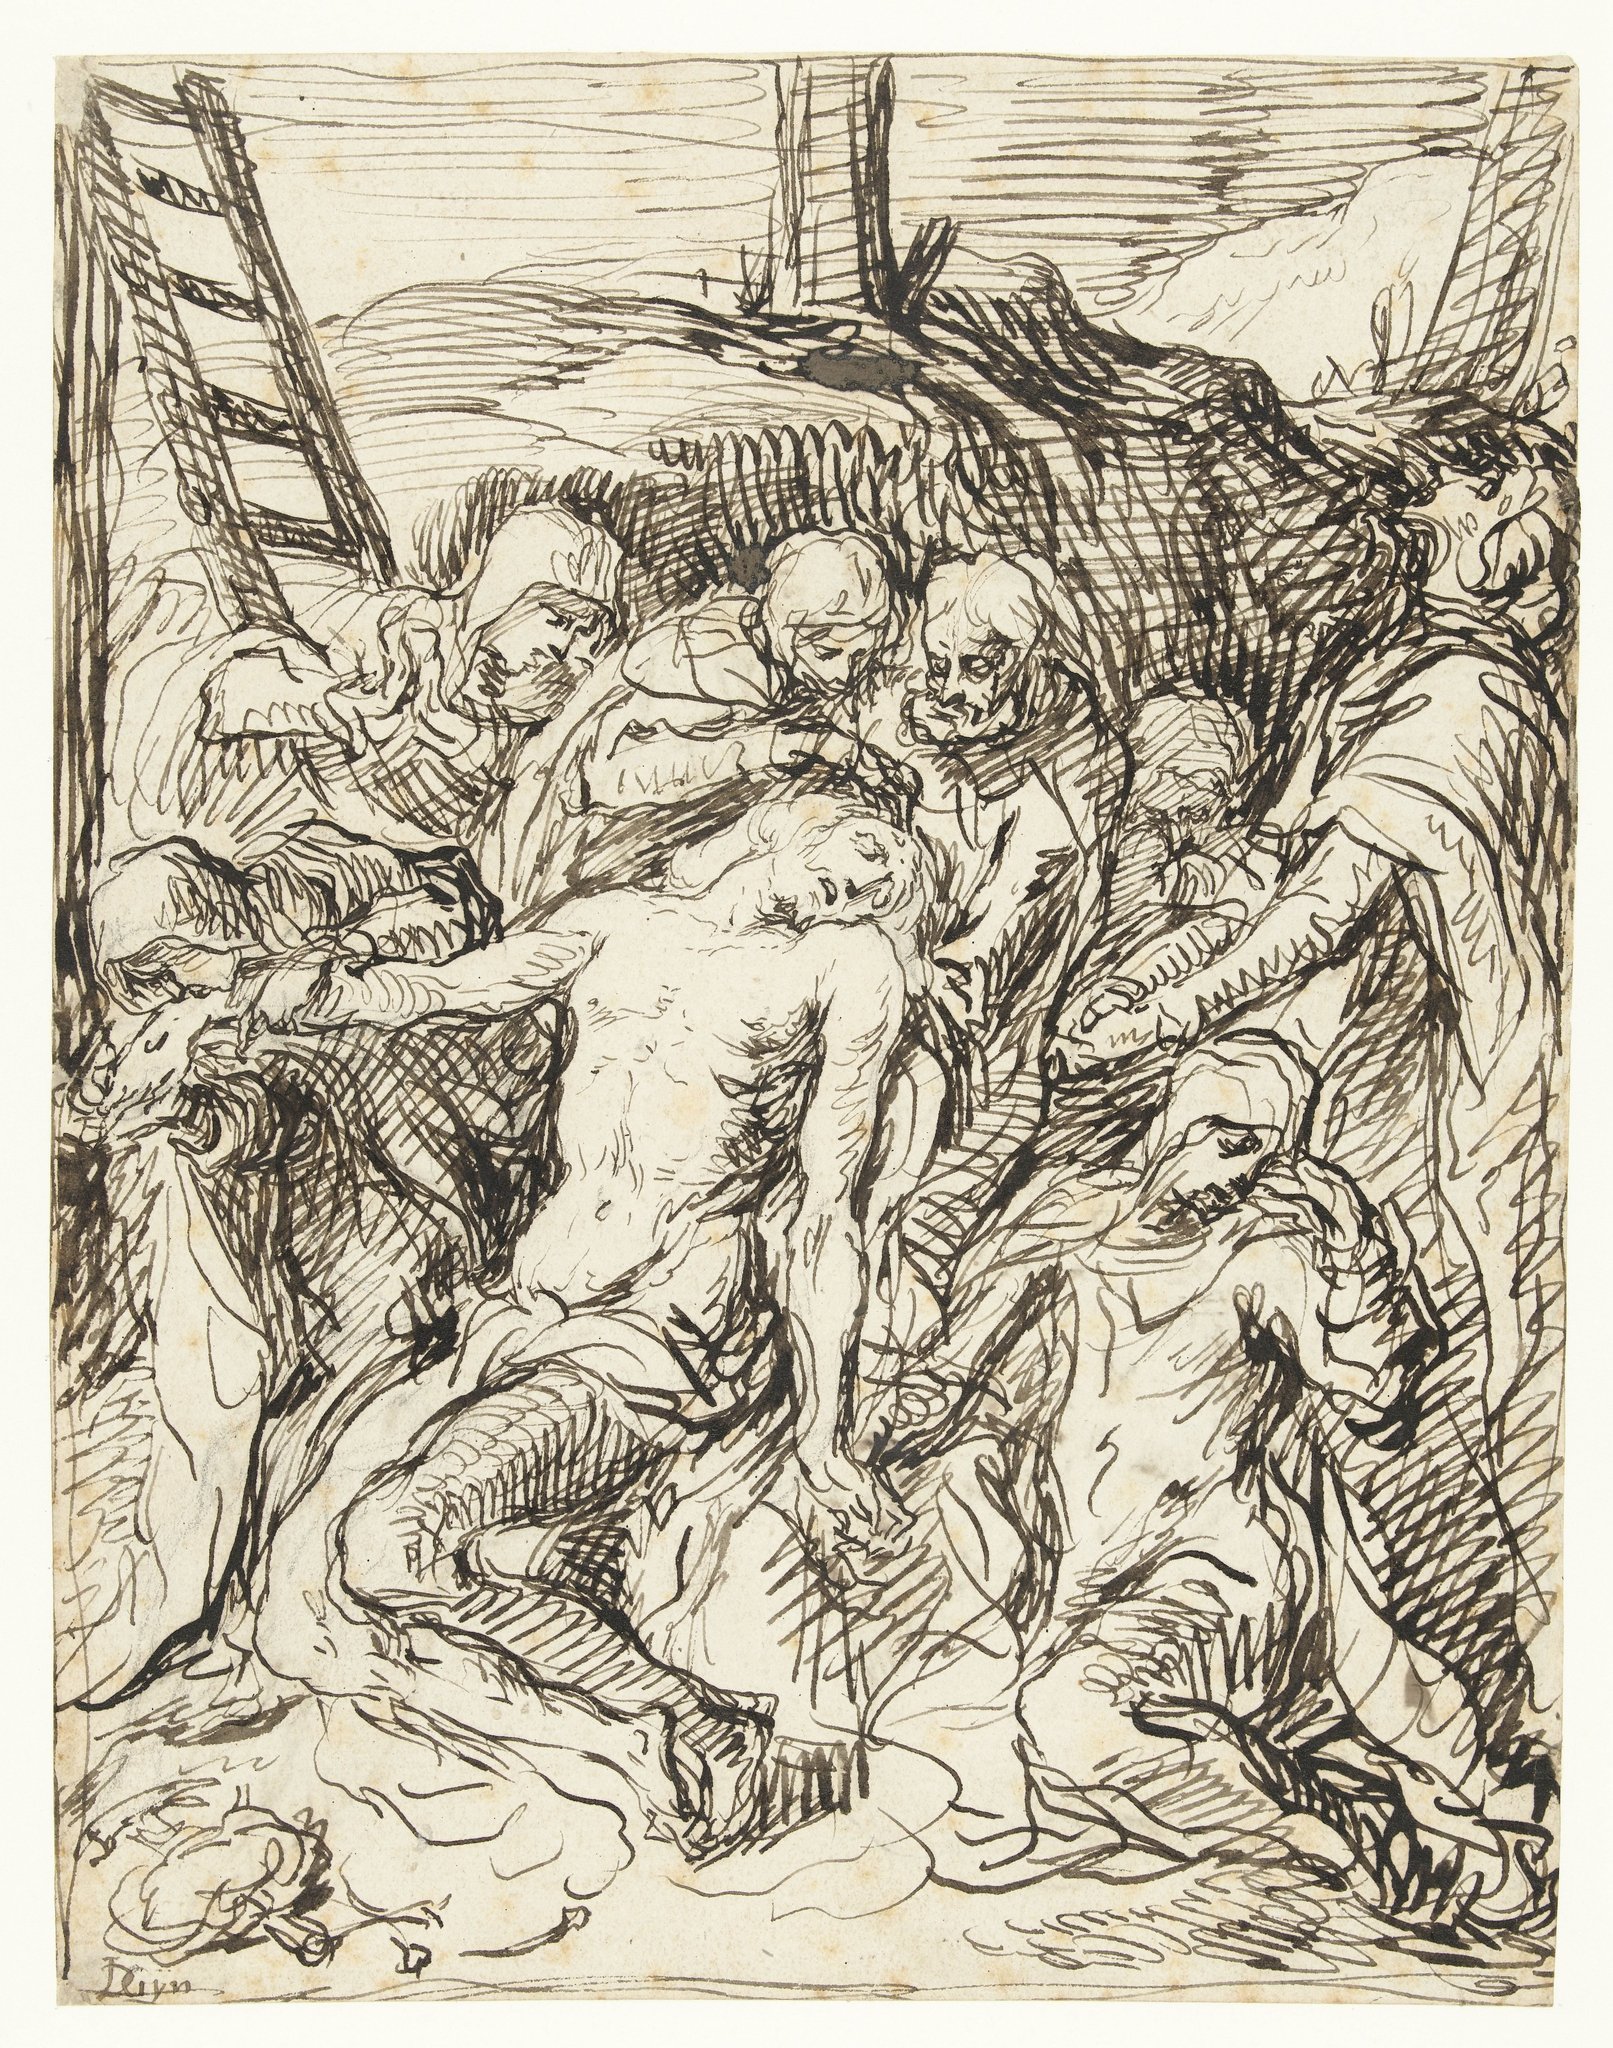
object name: drawing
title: Bewening van Christus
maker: jacques de gheyn (ii)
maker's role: painter, print maker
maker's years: 1565-1629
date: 1620-1625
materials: ink, paper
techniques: pen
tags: lamentation over the dead christ by his relatives and friends (christ usually without crown of thorns)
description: Van het kruis genomen, wordt Christus ondersteund door Jozef van Arimathea. Twee vrouwen houden zijn doorboorde handen vast; een derde vrouw, kijkt op hem neer, huilt en wringt haar handen. Rechts Johannes de Doper met zijn hoofd achterover gegooid kijkt omhoog. Verso: dezelfde scene met verscheidene veranderingen zodat de relatie tussen Christus en de huilende vrouwen is veranderd.